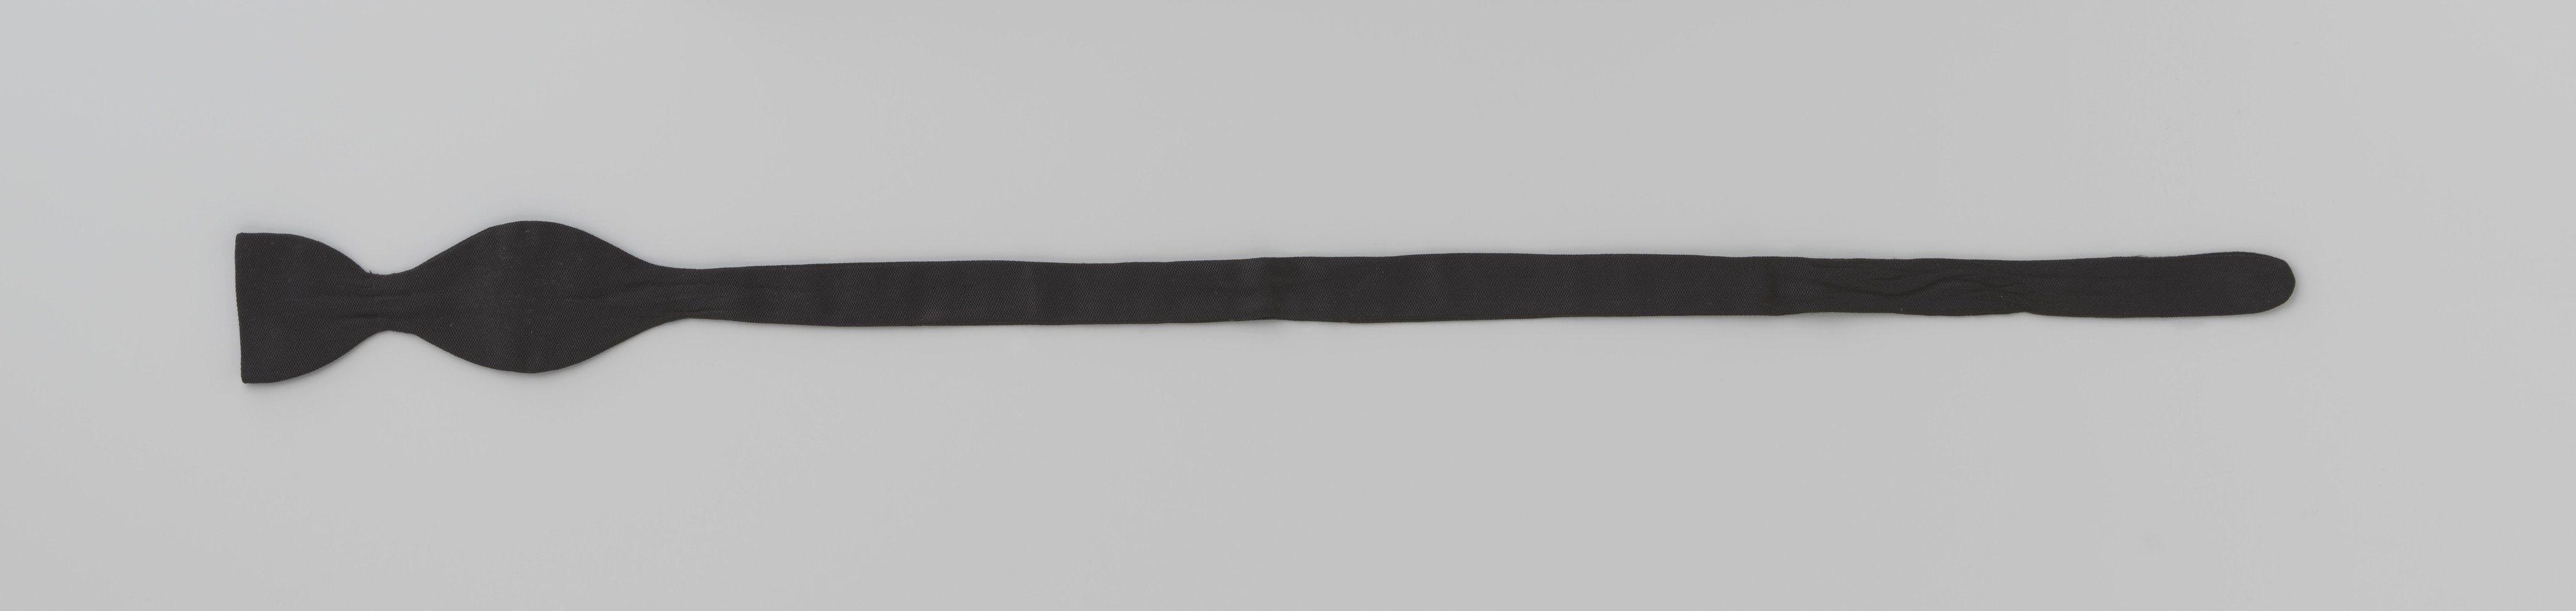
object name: menswear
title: Zwarte strik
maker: Anonymous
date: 1920-1980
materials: textile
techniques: weave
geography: europe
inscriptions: label: ‘Paul Emy’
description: Zwarte strik met aan de binnenzijde een label.